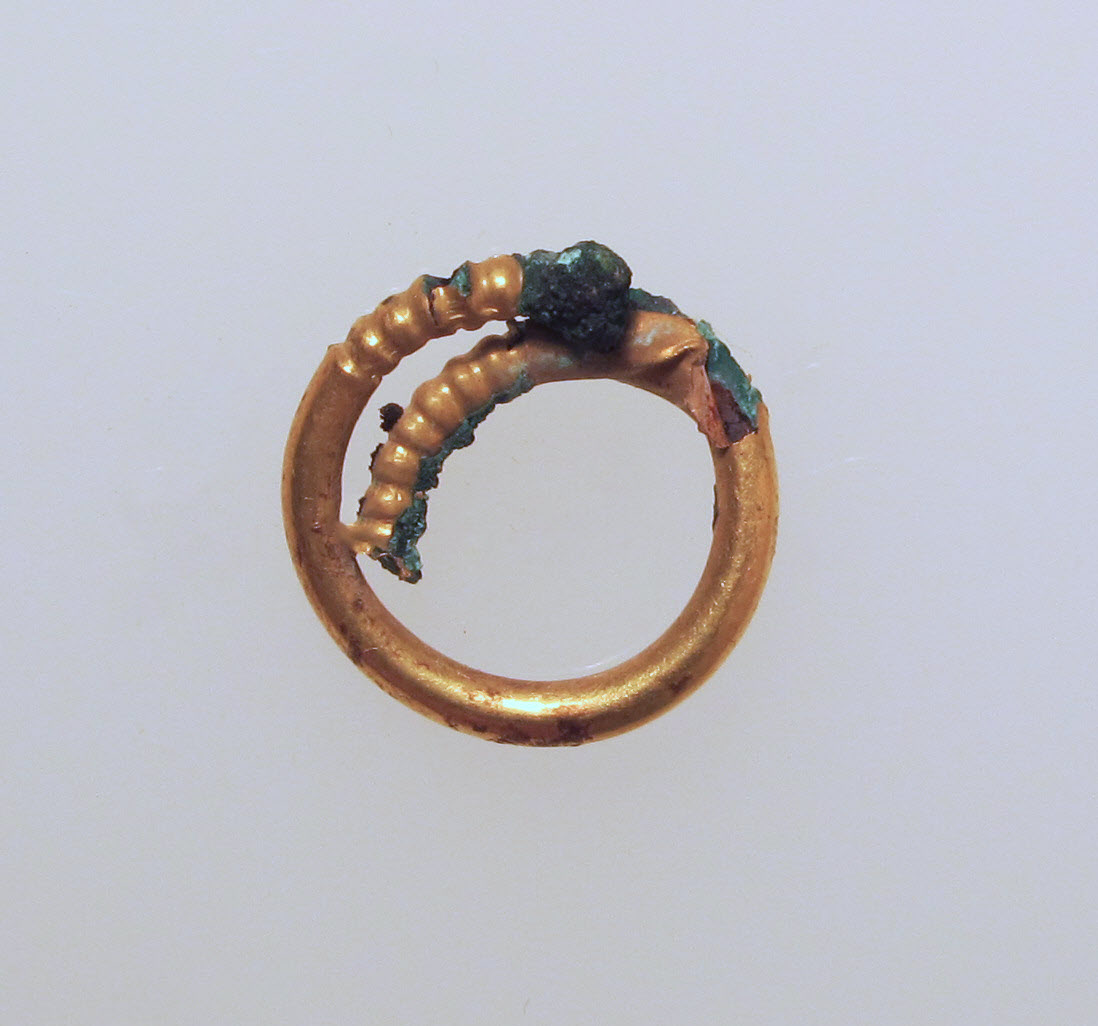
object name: earring or spiral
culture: cypriot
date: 3900 BCE-100 CE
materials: bronze, gold